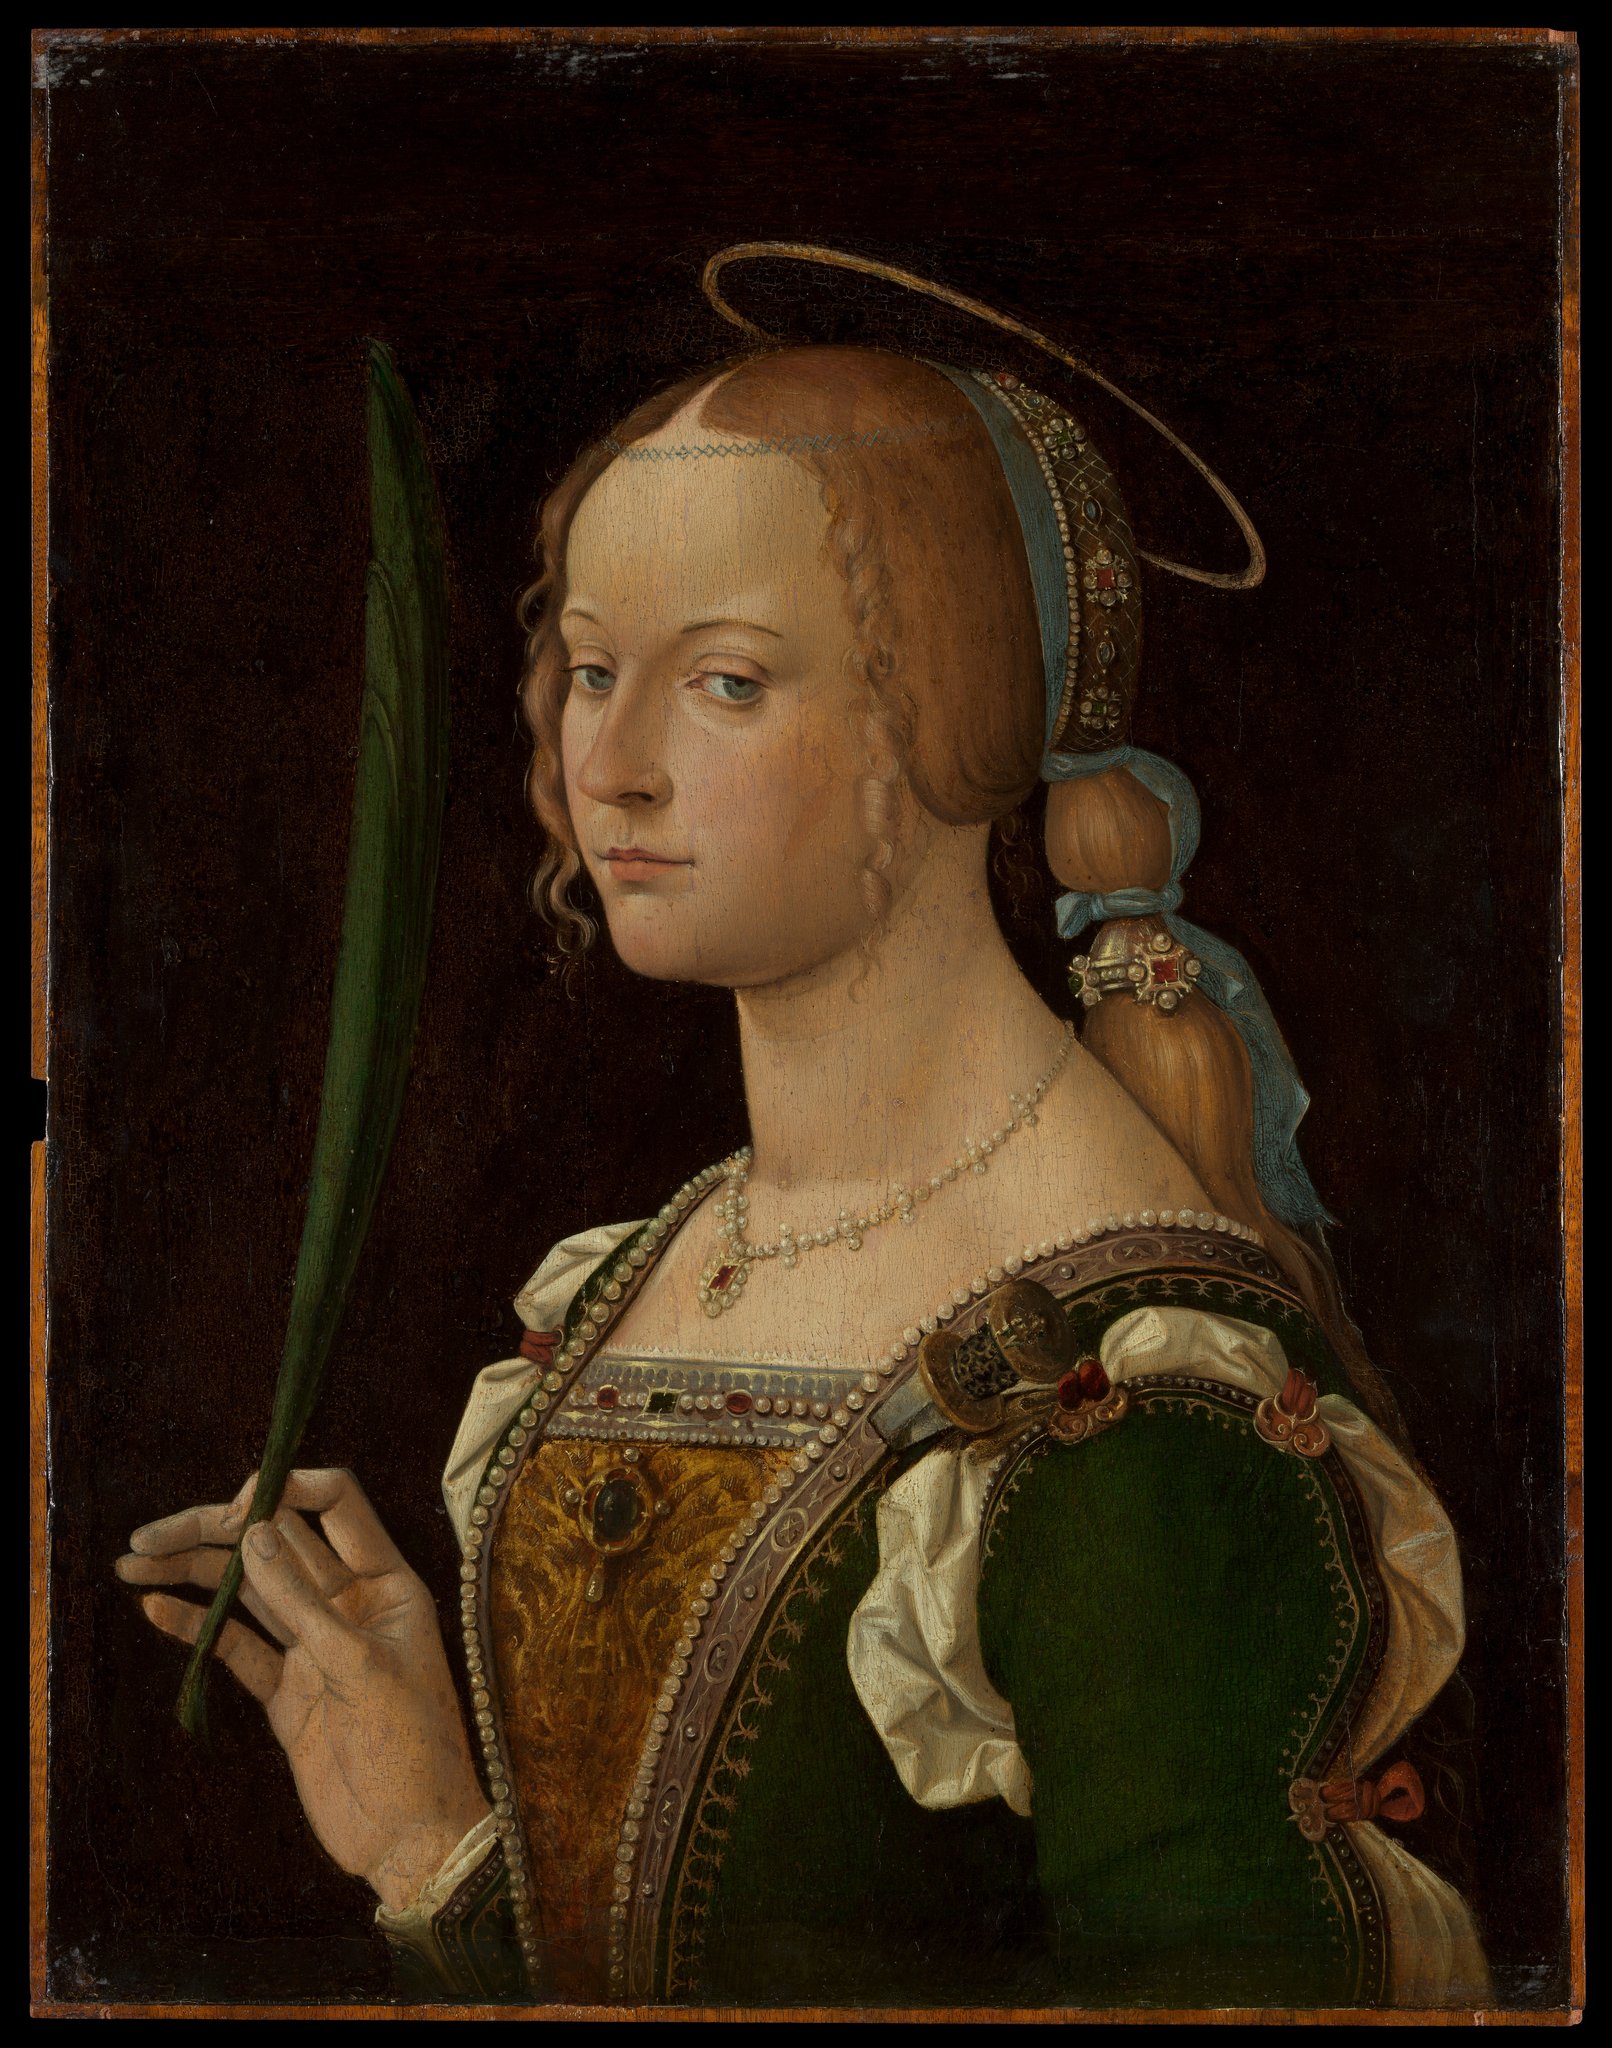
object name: painting fragment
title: Saint Justina of Padua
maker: bartolomeo montagna (bartolomeo cincani)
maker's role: artist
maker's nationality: italian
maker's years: 1459-1523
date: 1490-1499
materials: oil, wood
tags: portraits,women,saints